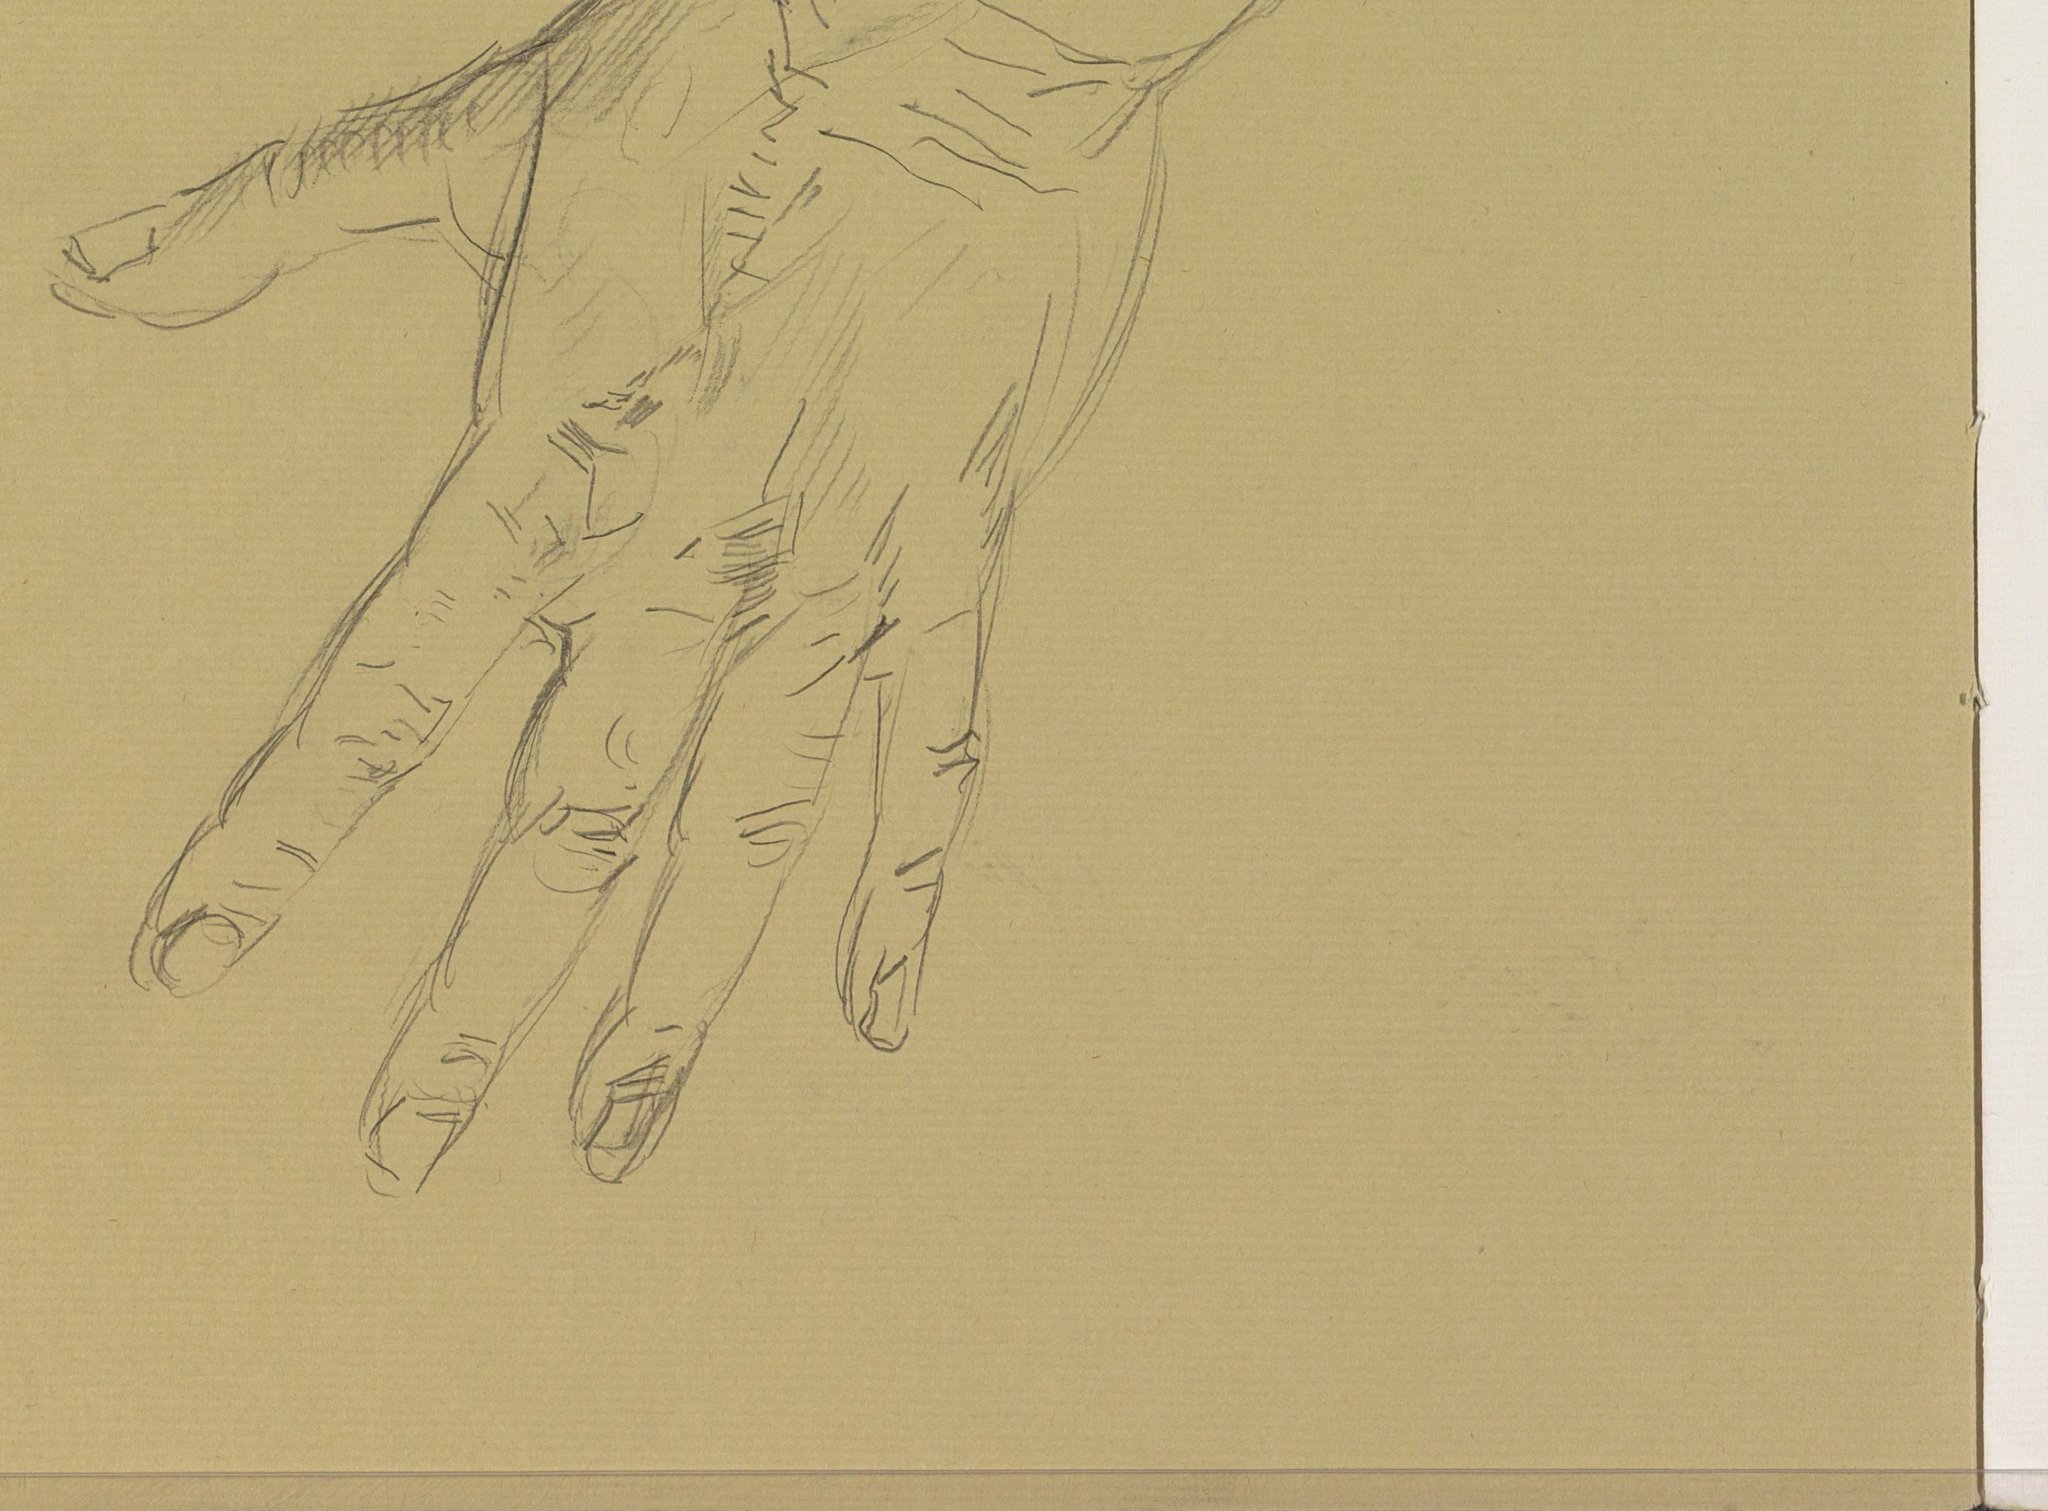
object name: sketchbook leaf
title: Hand met gespreide vingers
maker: isaac israels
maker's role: draughtsman, painter, print maker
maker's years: 1865-1934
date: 1875-1934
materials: paper, pencil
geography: the hague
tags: fingers spread out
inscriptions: watermark: ‘Holland’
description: Blad 2 verso uit schetsboek IV met 27 bladen.